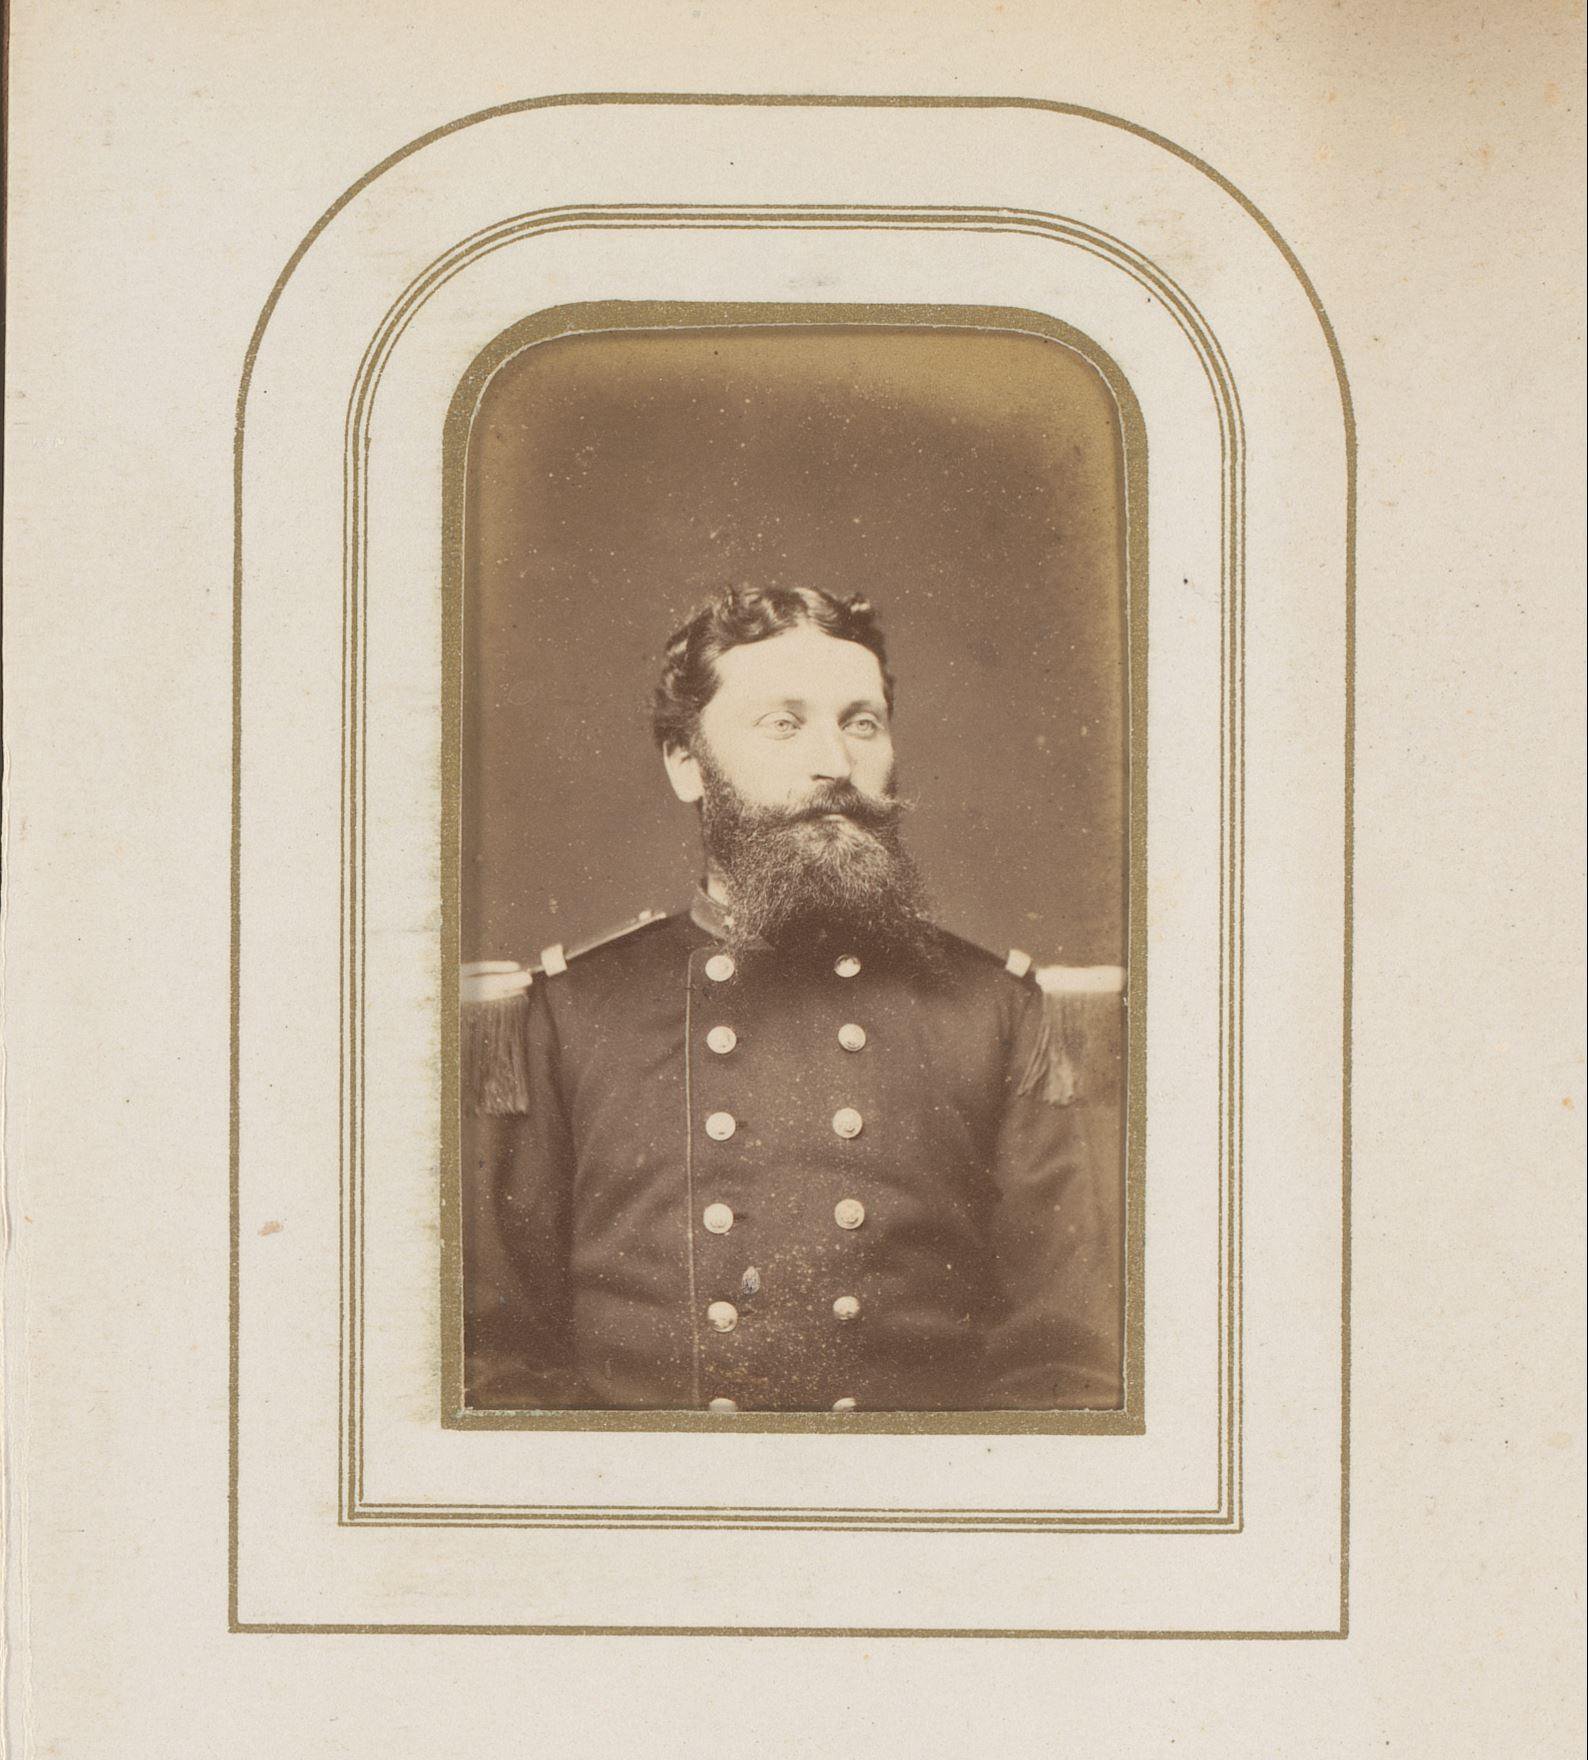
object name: carte de visite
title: Portret van een man met baard in uniform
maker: auguste chapuis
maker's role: fotograaf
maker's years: 1837-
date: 1868-1888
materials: cardboard, photographic support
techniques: albumen print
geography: bergen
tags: historical persons, (military) uniforms, beard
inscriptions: inscription: ‘Photographie du Hainaut/ Chapuis/ 15, rue du seminaire/ en face de l'athenée/ Mons’